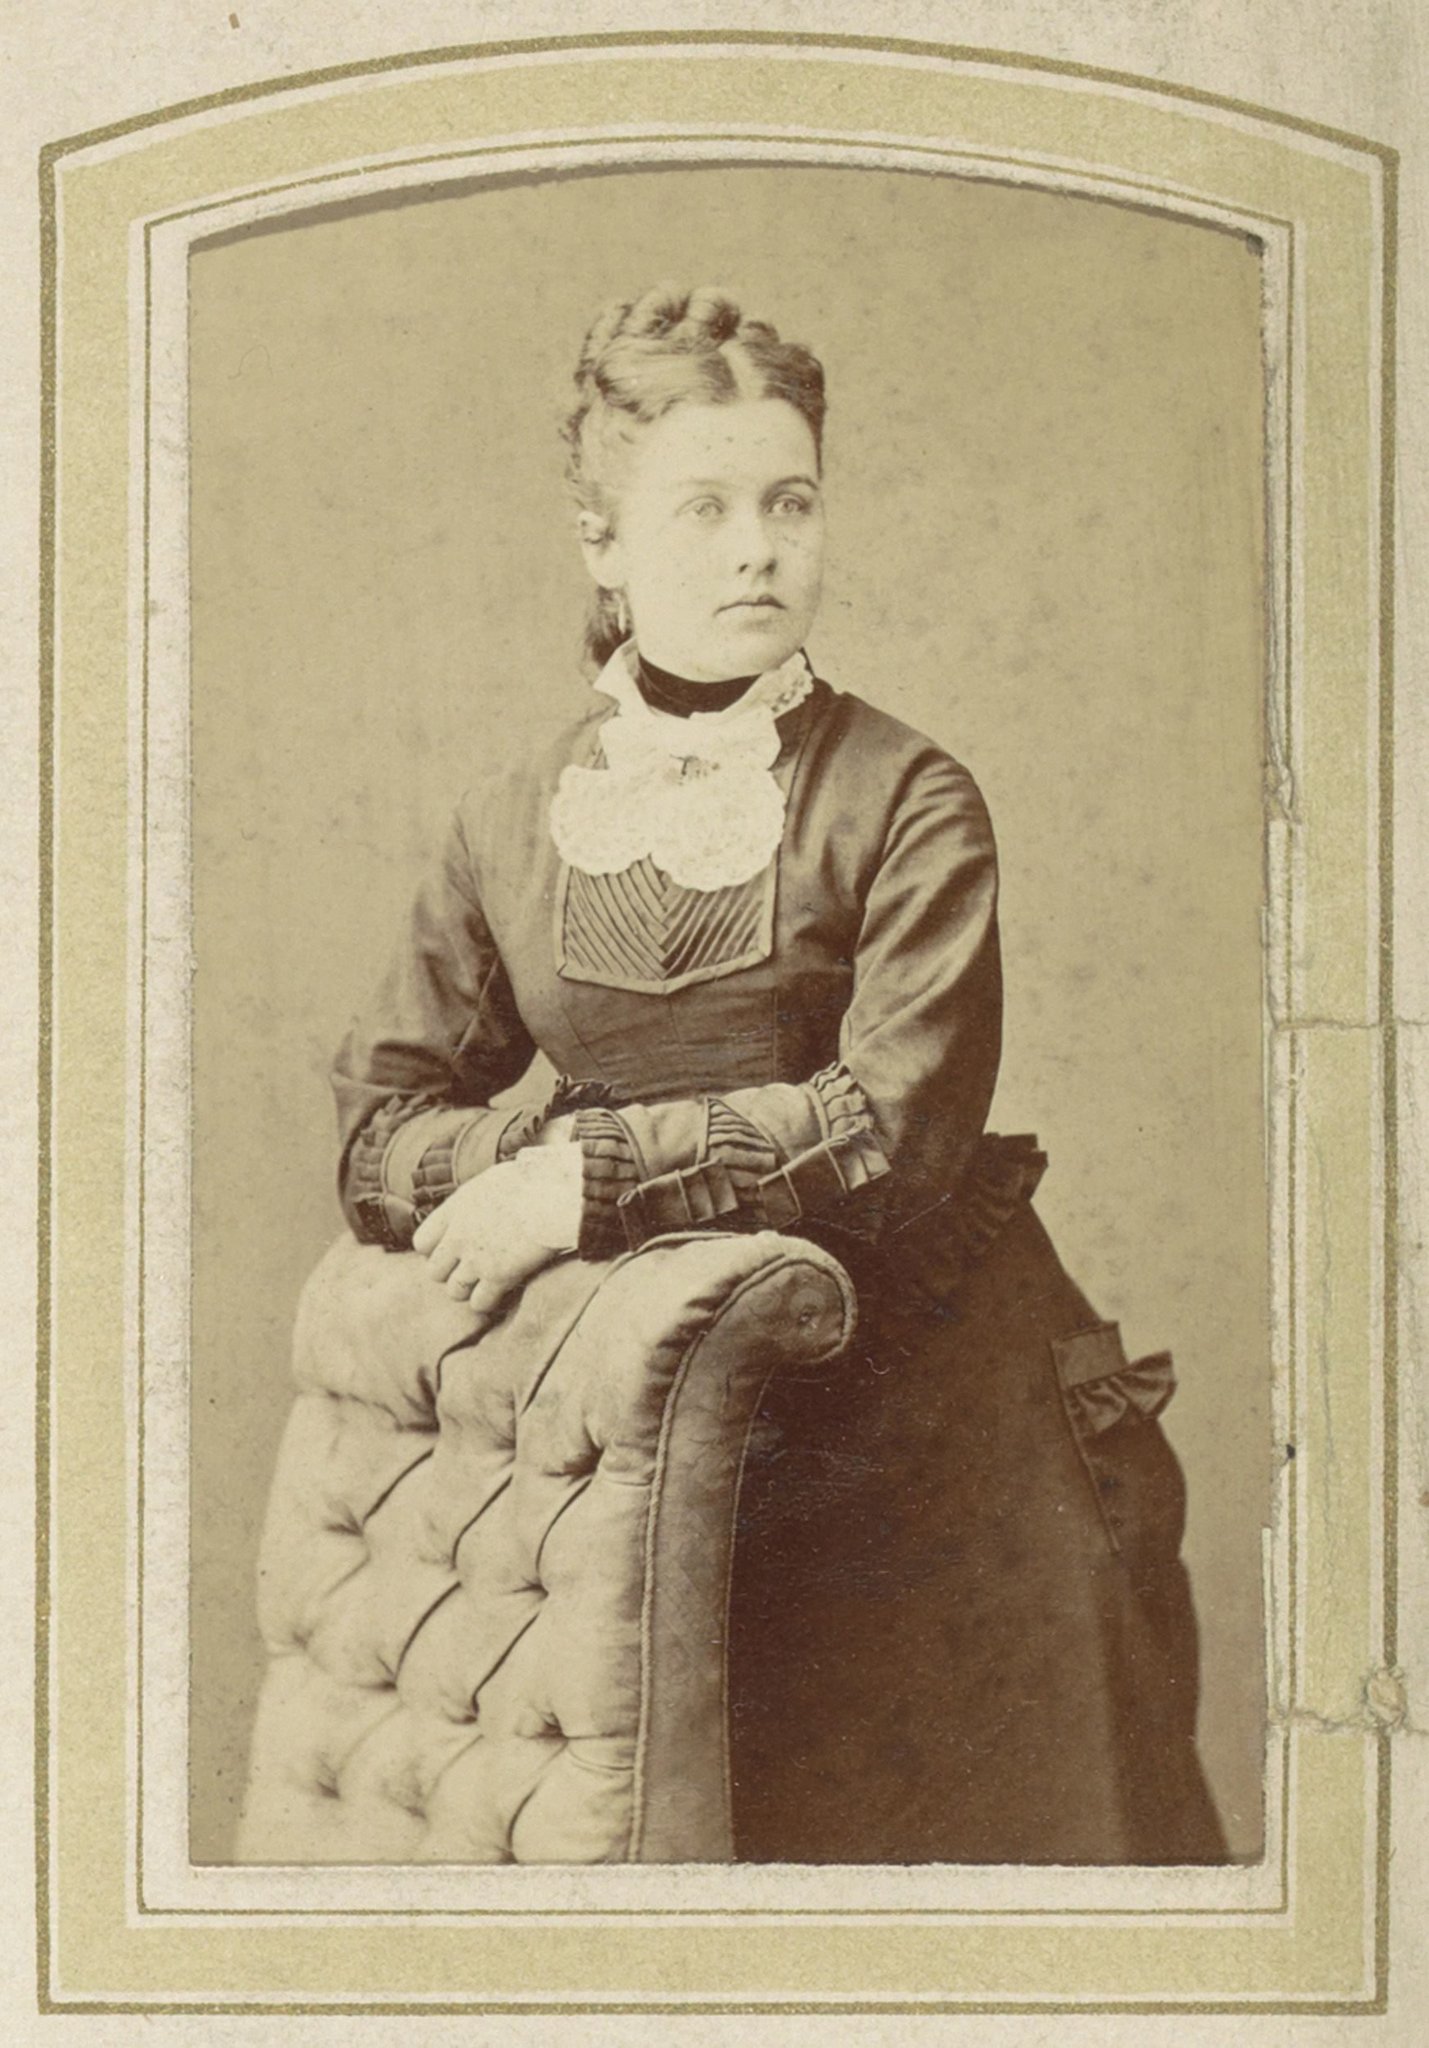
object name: photograph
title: Portret van een vrouw in een jurk leunend op een fauteuil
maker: Anonymous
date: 1860-1900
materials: cardboard, paper, photographic support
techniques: albumen print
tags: studio requisites ~ photographer, clothing for the lower part of the body, historical persons, clothing for the upper part of the body, dress, gown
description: Onderdeel van Fotoalbum van een Nederlandse familie met 168 cartes-de-visite en kabinetfoto's.